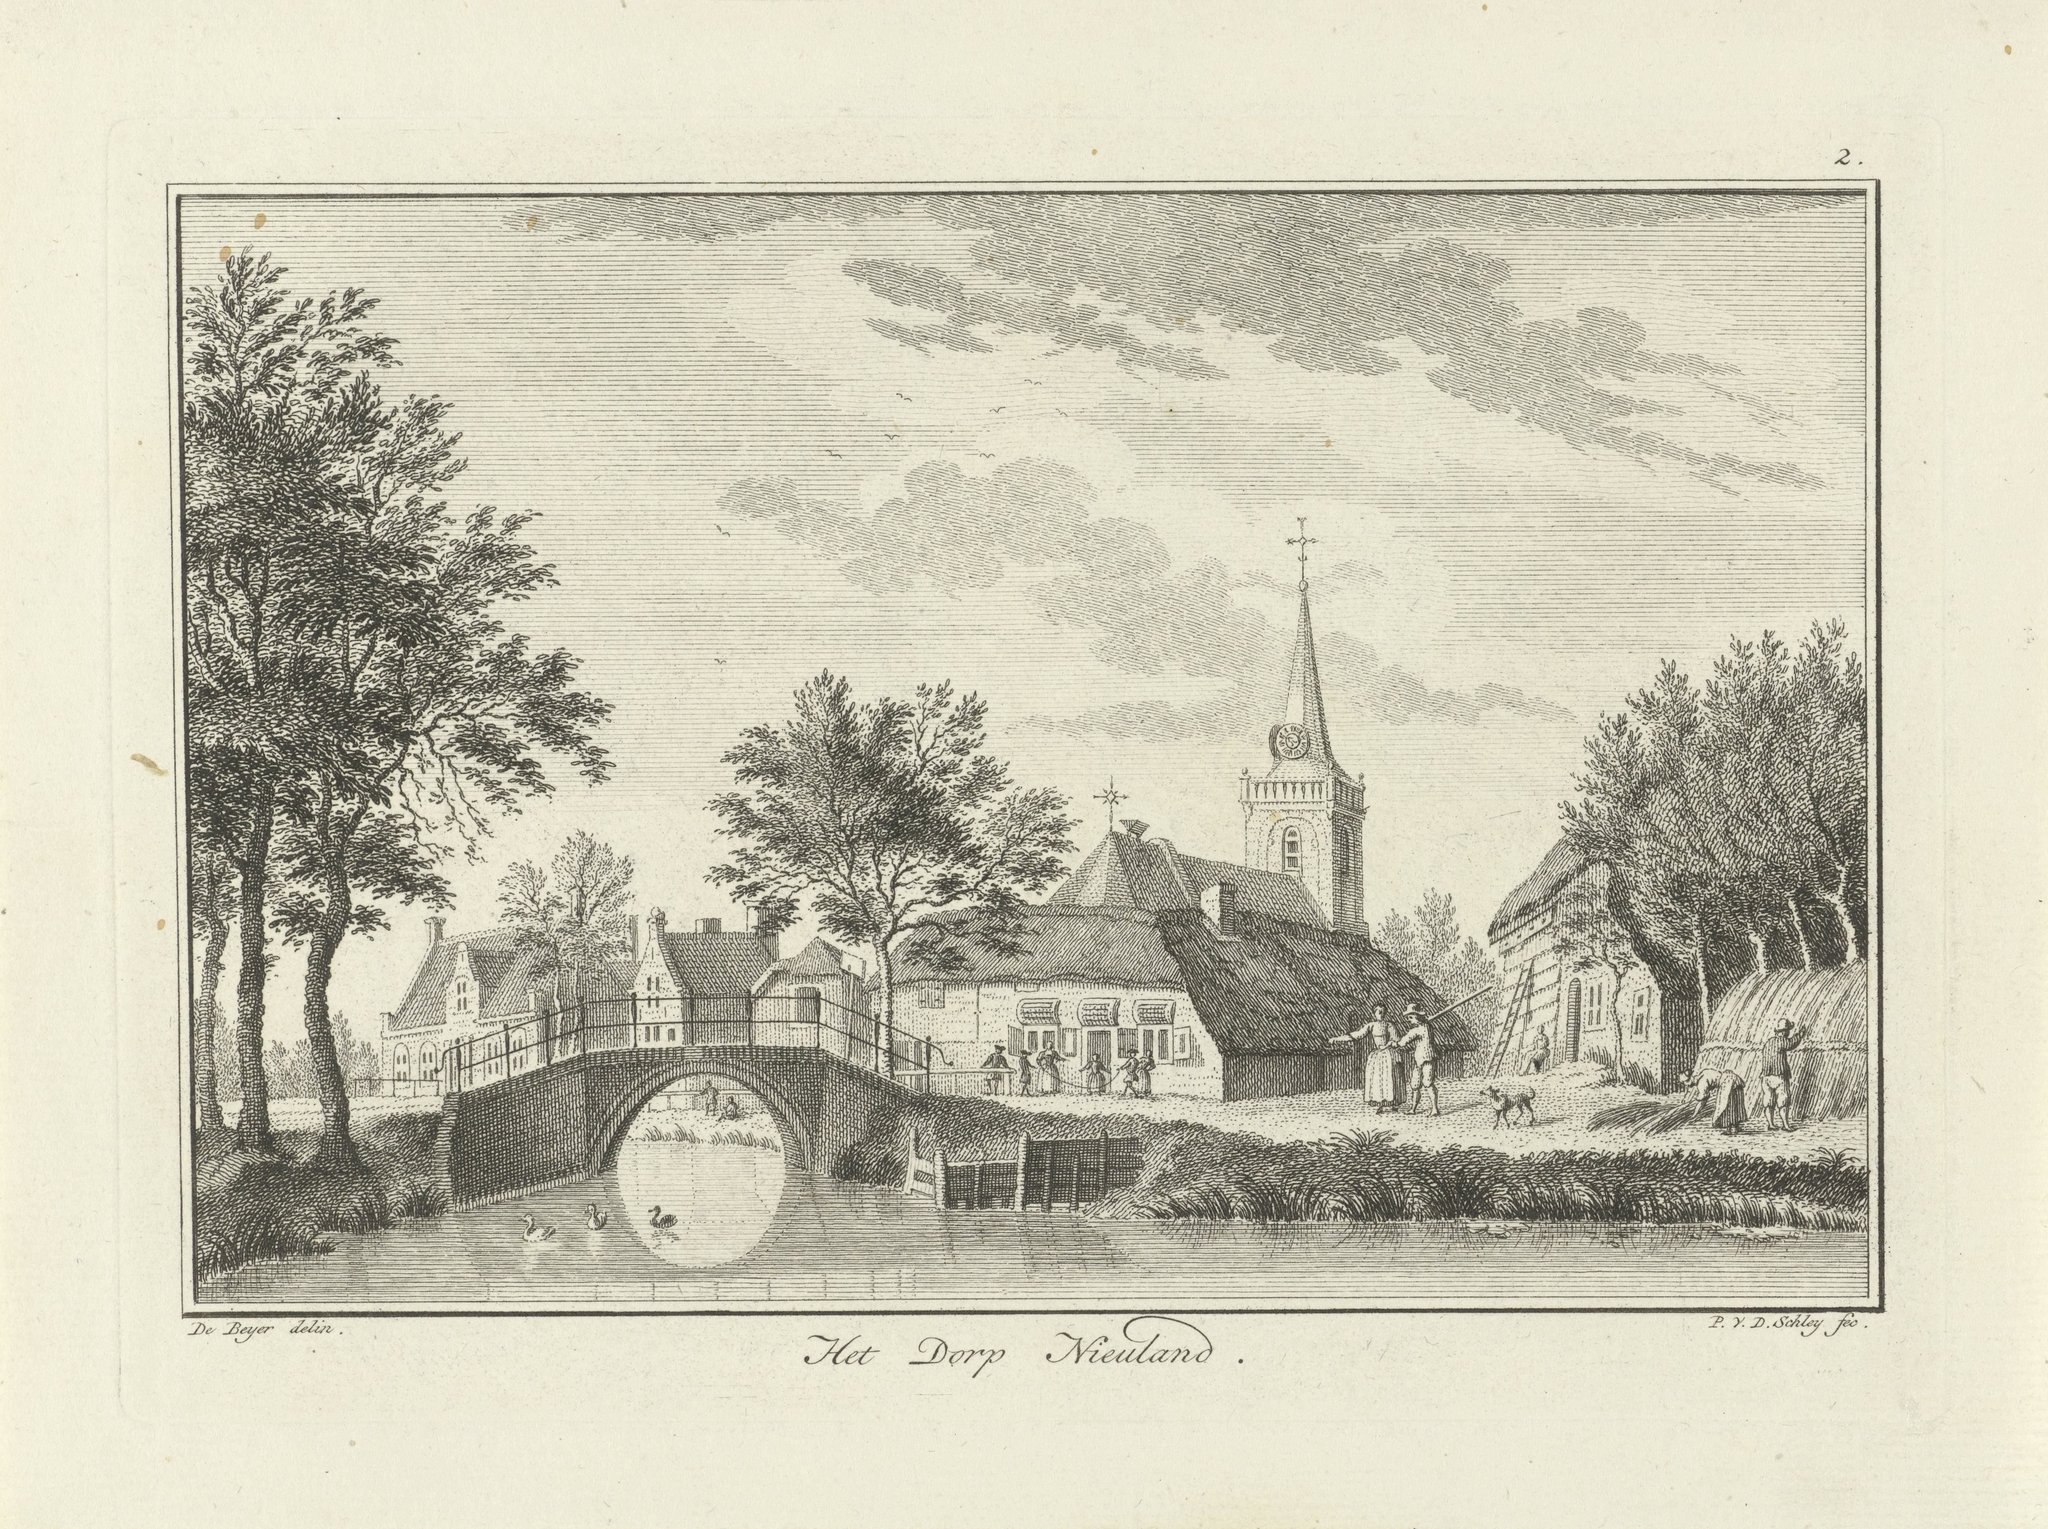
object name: print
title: Het dorp Nieuland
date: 1750-1817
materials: paper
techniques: etching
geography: netherlands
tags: prospect of village, silhouette of village, church (exterior), jumping-rope games, bridge in village across river, canal, etc.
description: Gezicht op het dorp Nieuwland in de buurt van Gorinchem. Links een brug en rechts op de achtergrond de kerk. Bij het dorp bevinden zich verschillende figuren, waaronder touwtje springende kinderen. Rechtsboven genummerd: 2.